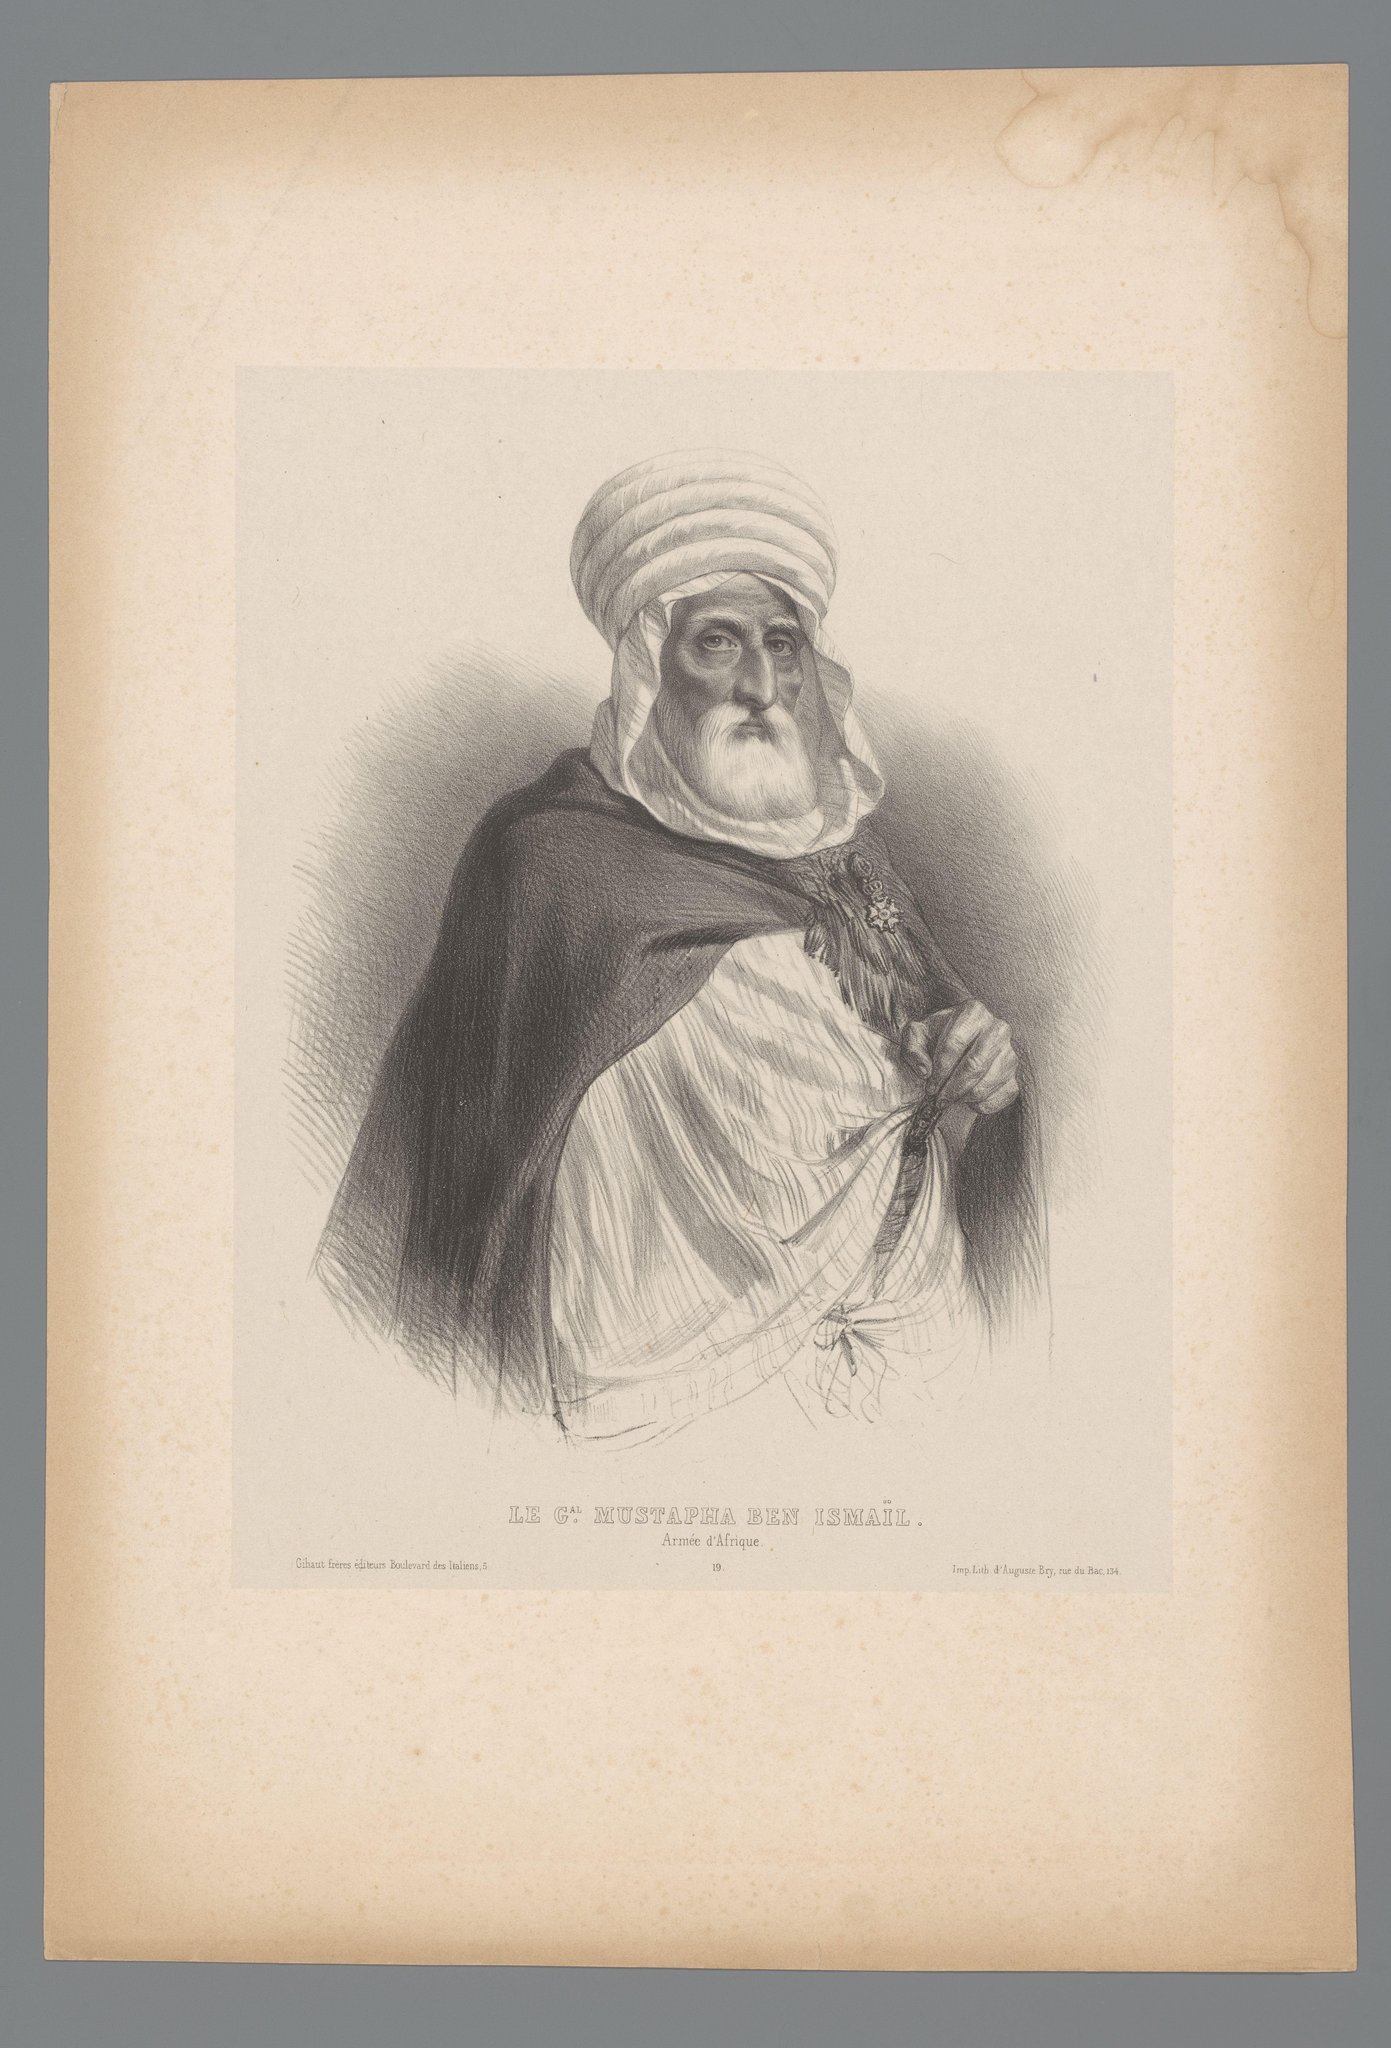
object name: print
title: Portret van de Franse generaal Mustapha Ben Ismaïl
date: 1842-1844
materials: paper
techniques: lithograph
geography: paris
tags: commander-in-chief, general, marshal, historical persons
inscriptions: collector's mark: Lugt 2228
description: Prent waarschijnlijk deel van Benjamins Roubauds prentserie: Souvenirs d'Afrique. Parijs: Gihaut frères, 1842-1846. In de eerste uitgeefronde (1842-1844) bracht hij individuele portretten uit. De prentmaker kwam in 1846 nog met aanvullende prenten voor deze serie onder de noemer 'inheemsen' (indigènes) met samengestelde afbeeeldingen en groepstaferelen (zie: https://www.splrarebooks.com/collection/view/album-dafrique/).